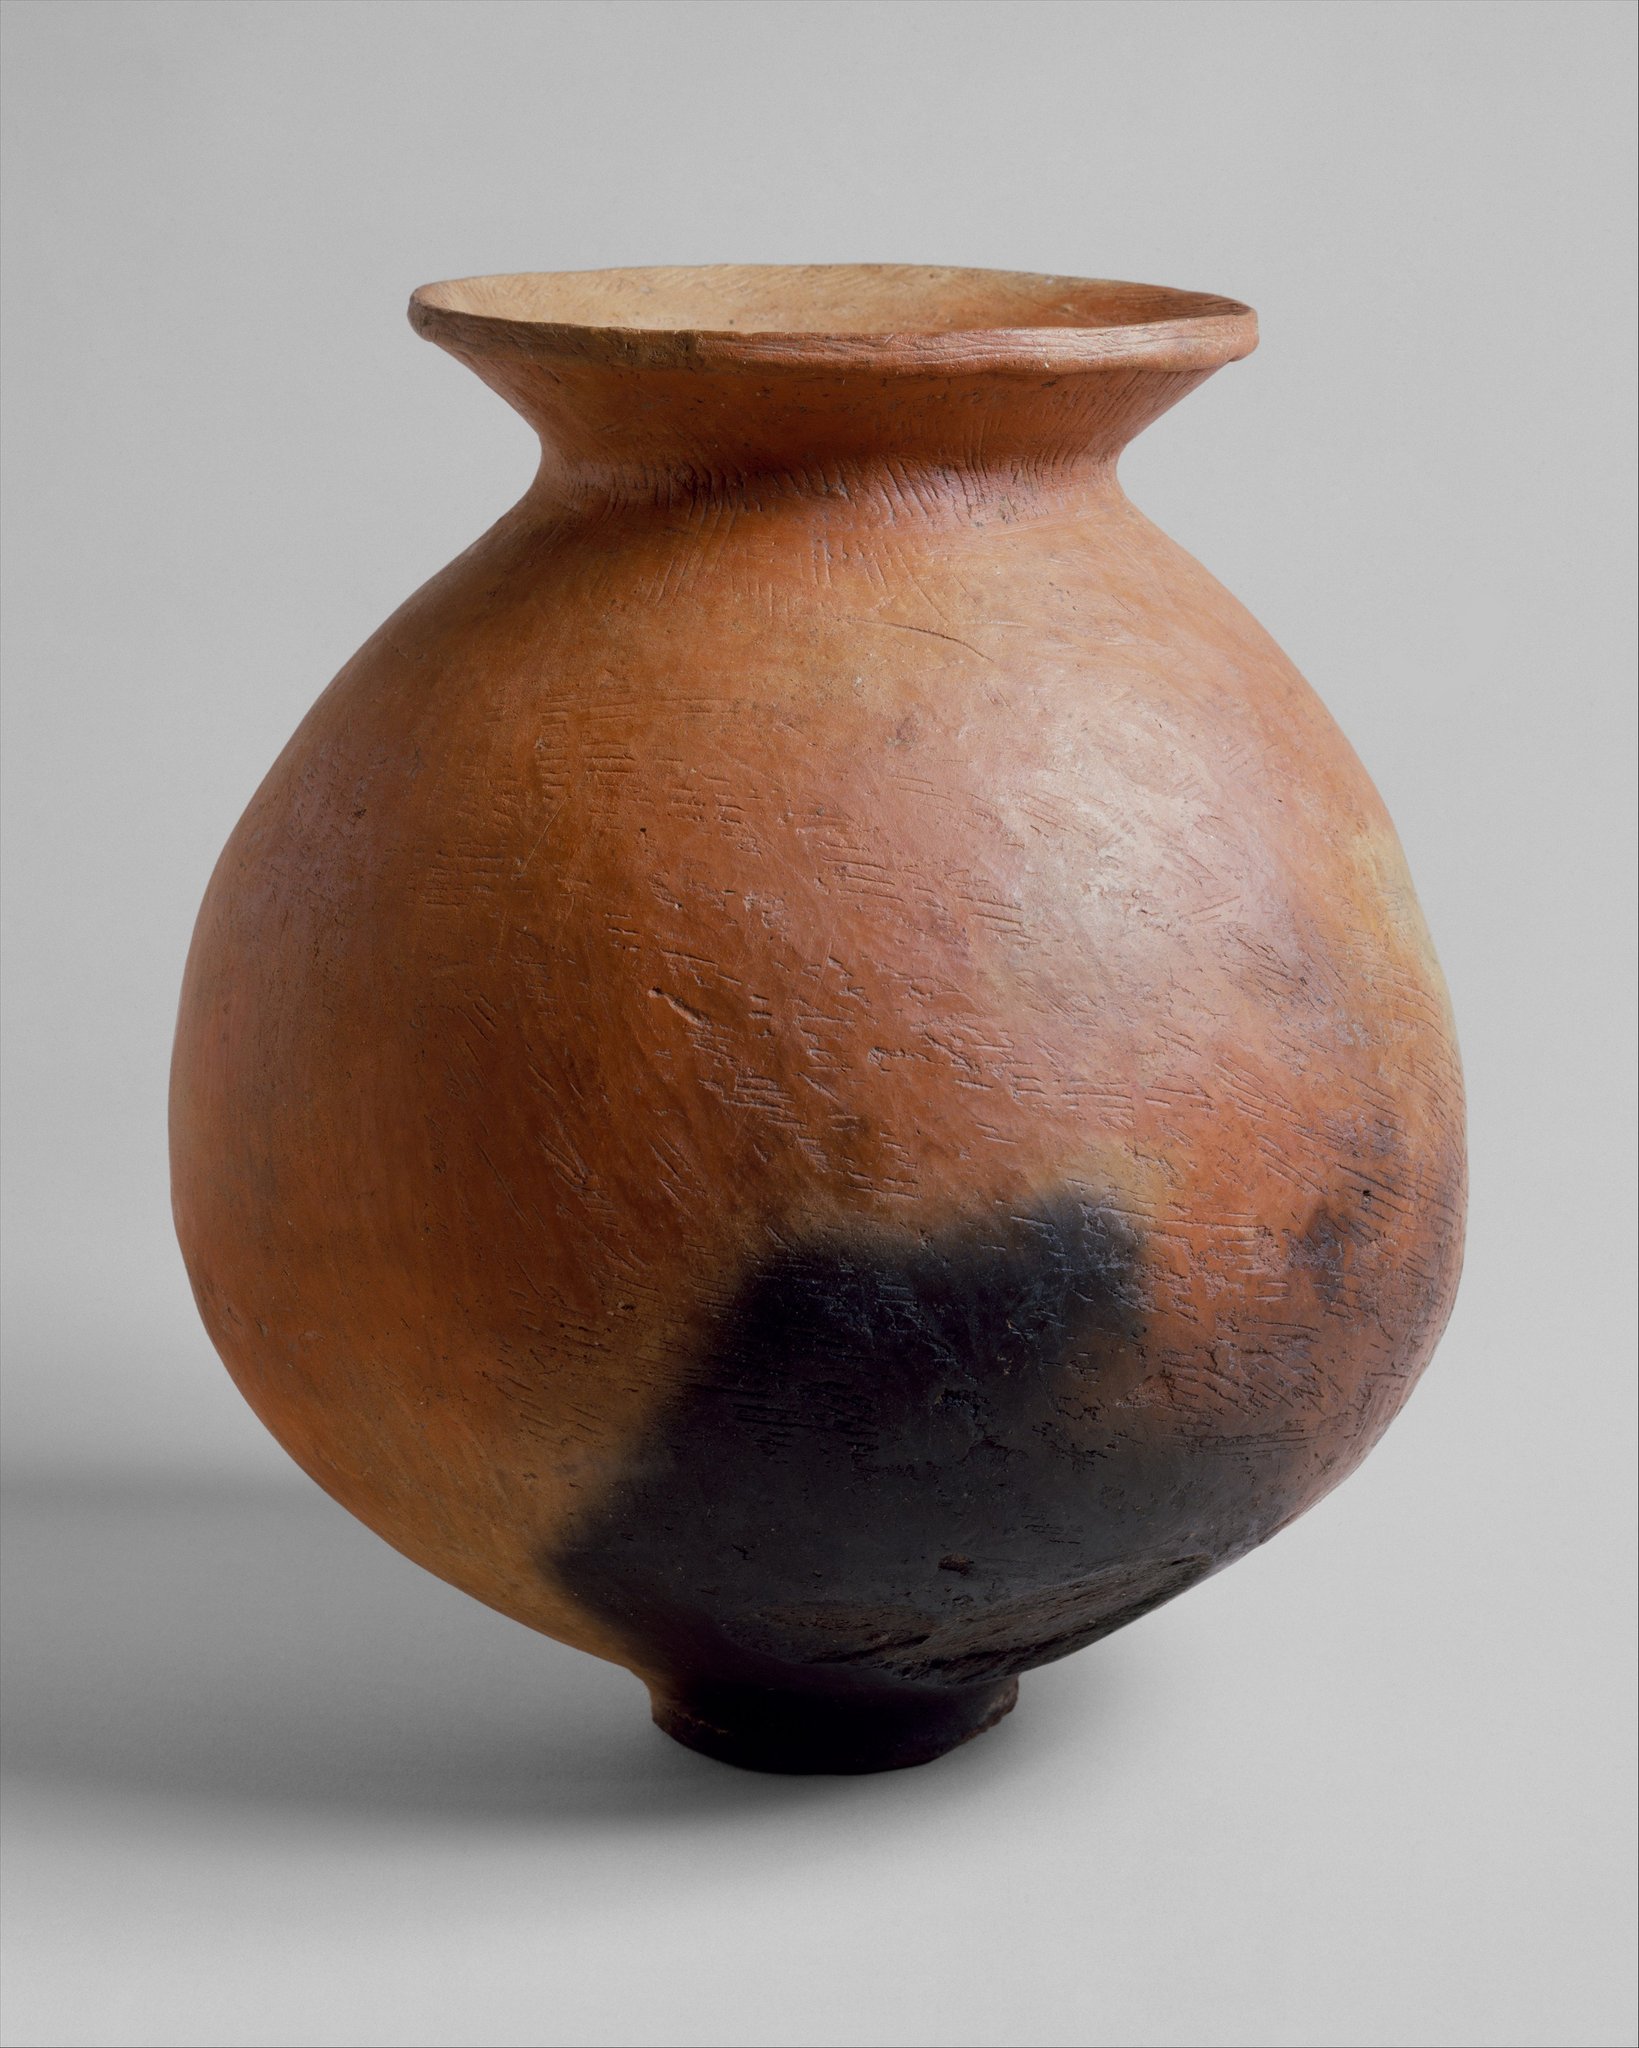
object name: jar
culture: japanese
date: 100-300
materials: earthenware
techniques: incising